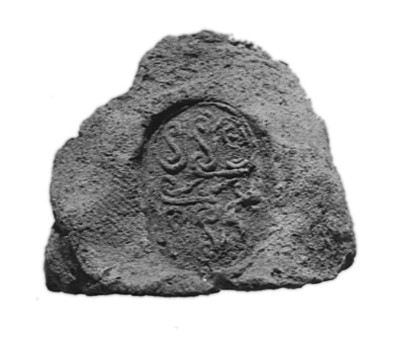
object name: sealing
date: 2030-1640 BCE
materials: clay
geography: egypt